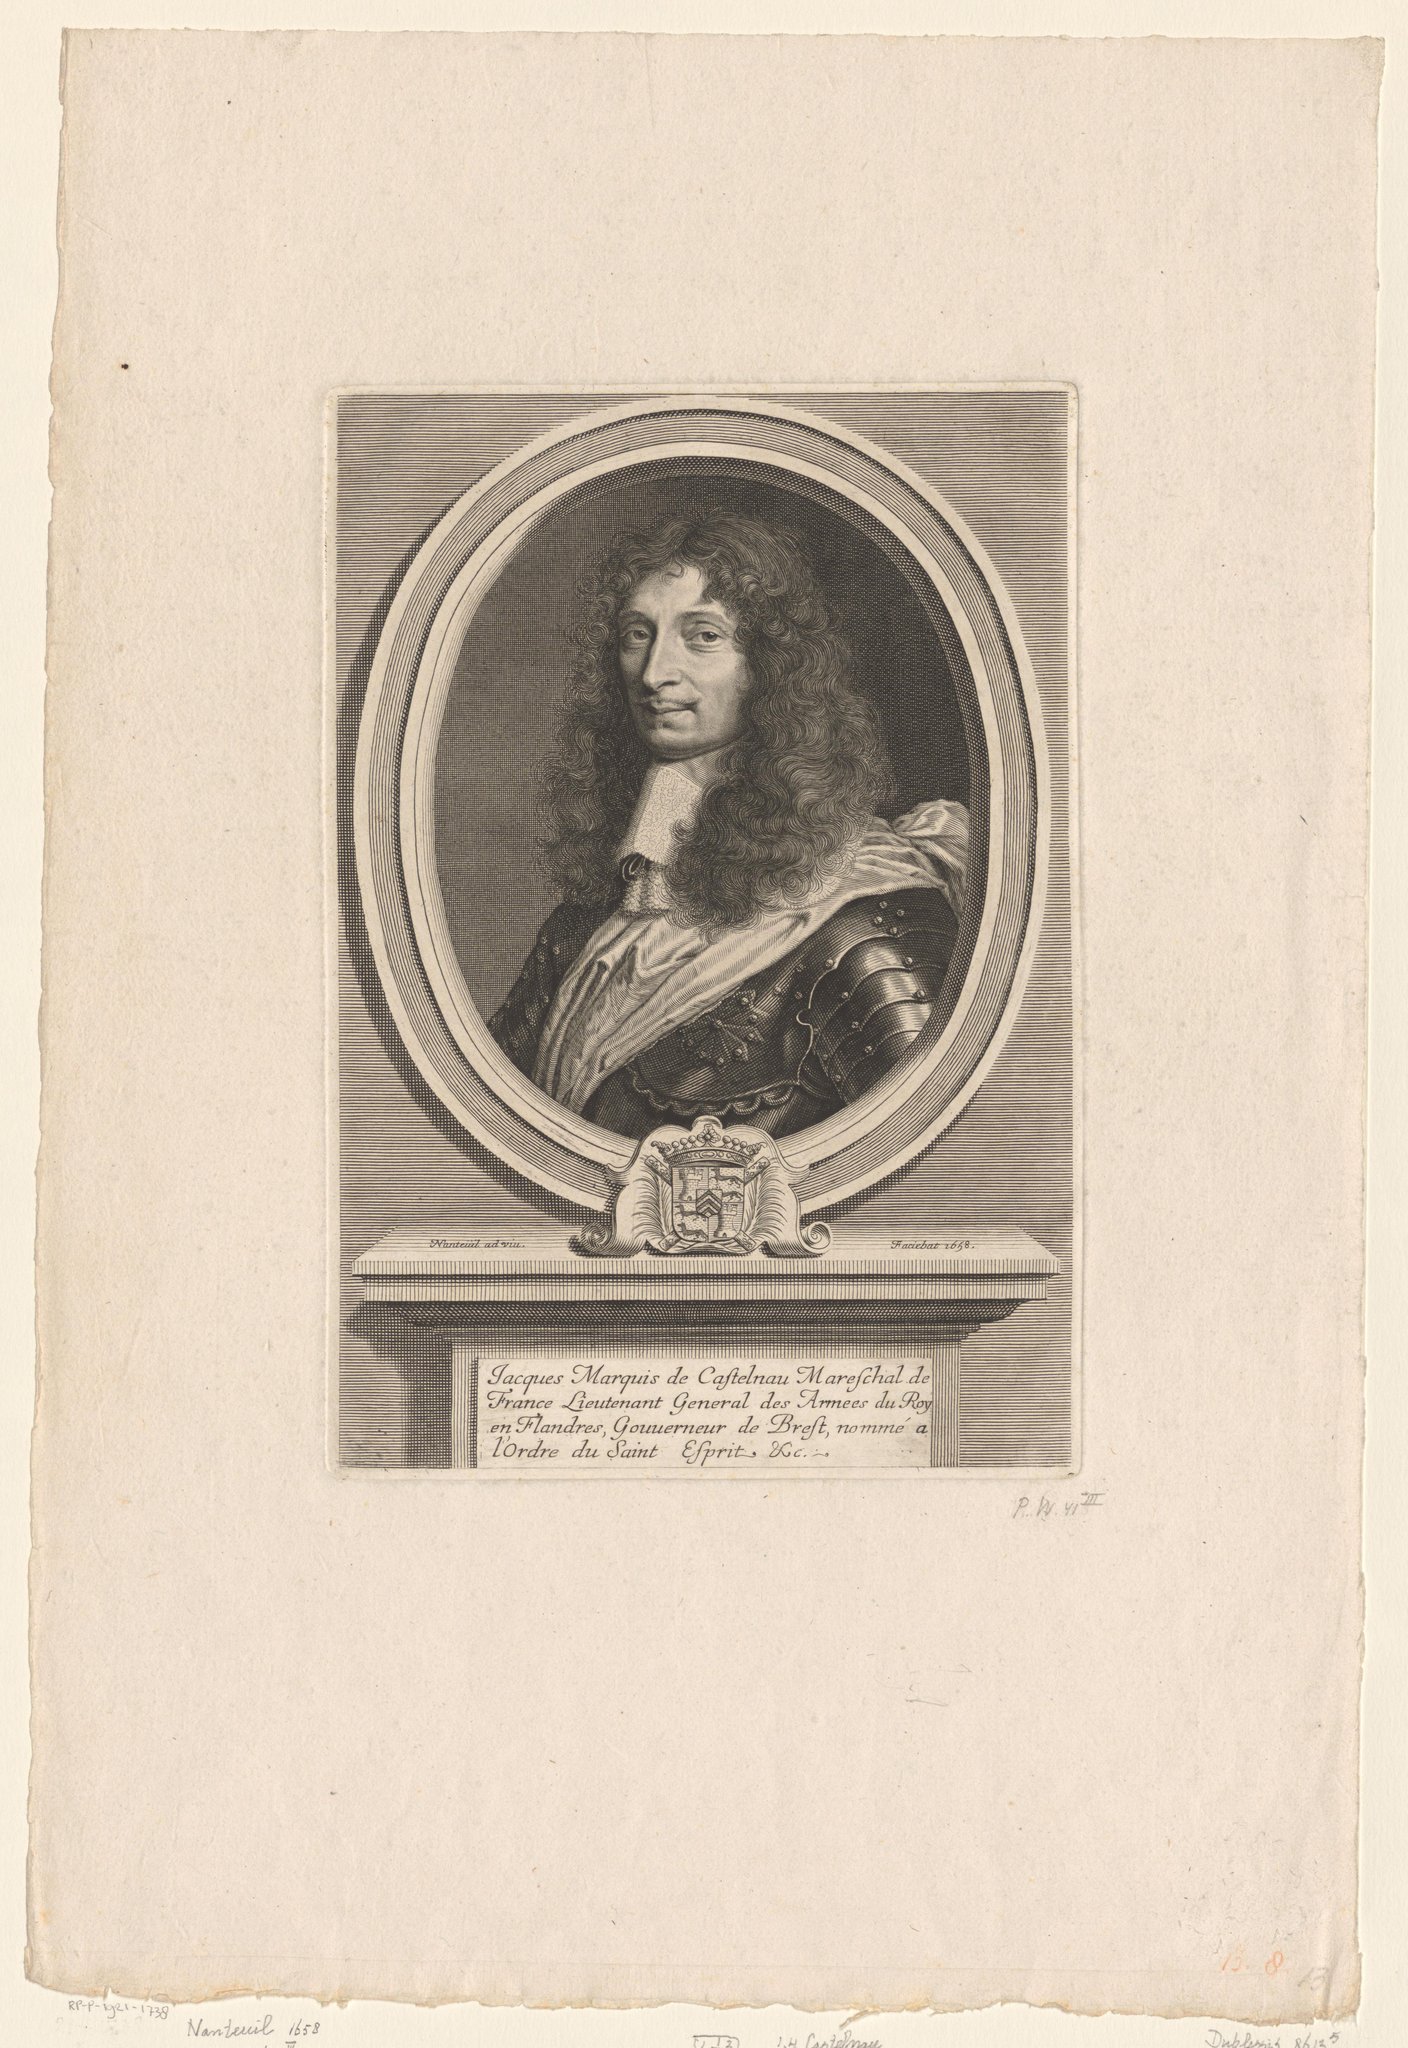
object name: print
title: Portret van Jacques de Castelnau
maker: robert nanteuil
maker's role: print maker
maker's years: 1623-1678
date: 1658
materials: paper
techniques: engraving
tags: historical persons, armorial bearing, heraldry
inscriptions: collector's mark: Lugt 2233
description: Prent mogelijk uit: Castelnau, Michel de. Les Mémoires de messire Michel de Castelnau (...). Parijs: Pierre Lamy, 1658.